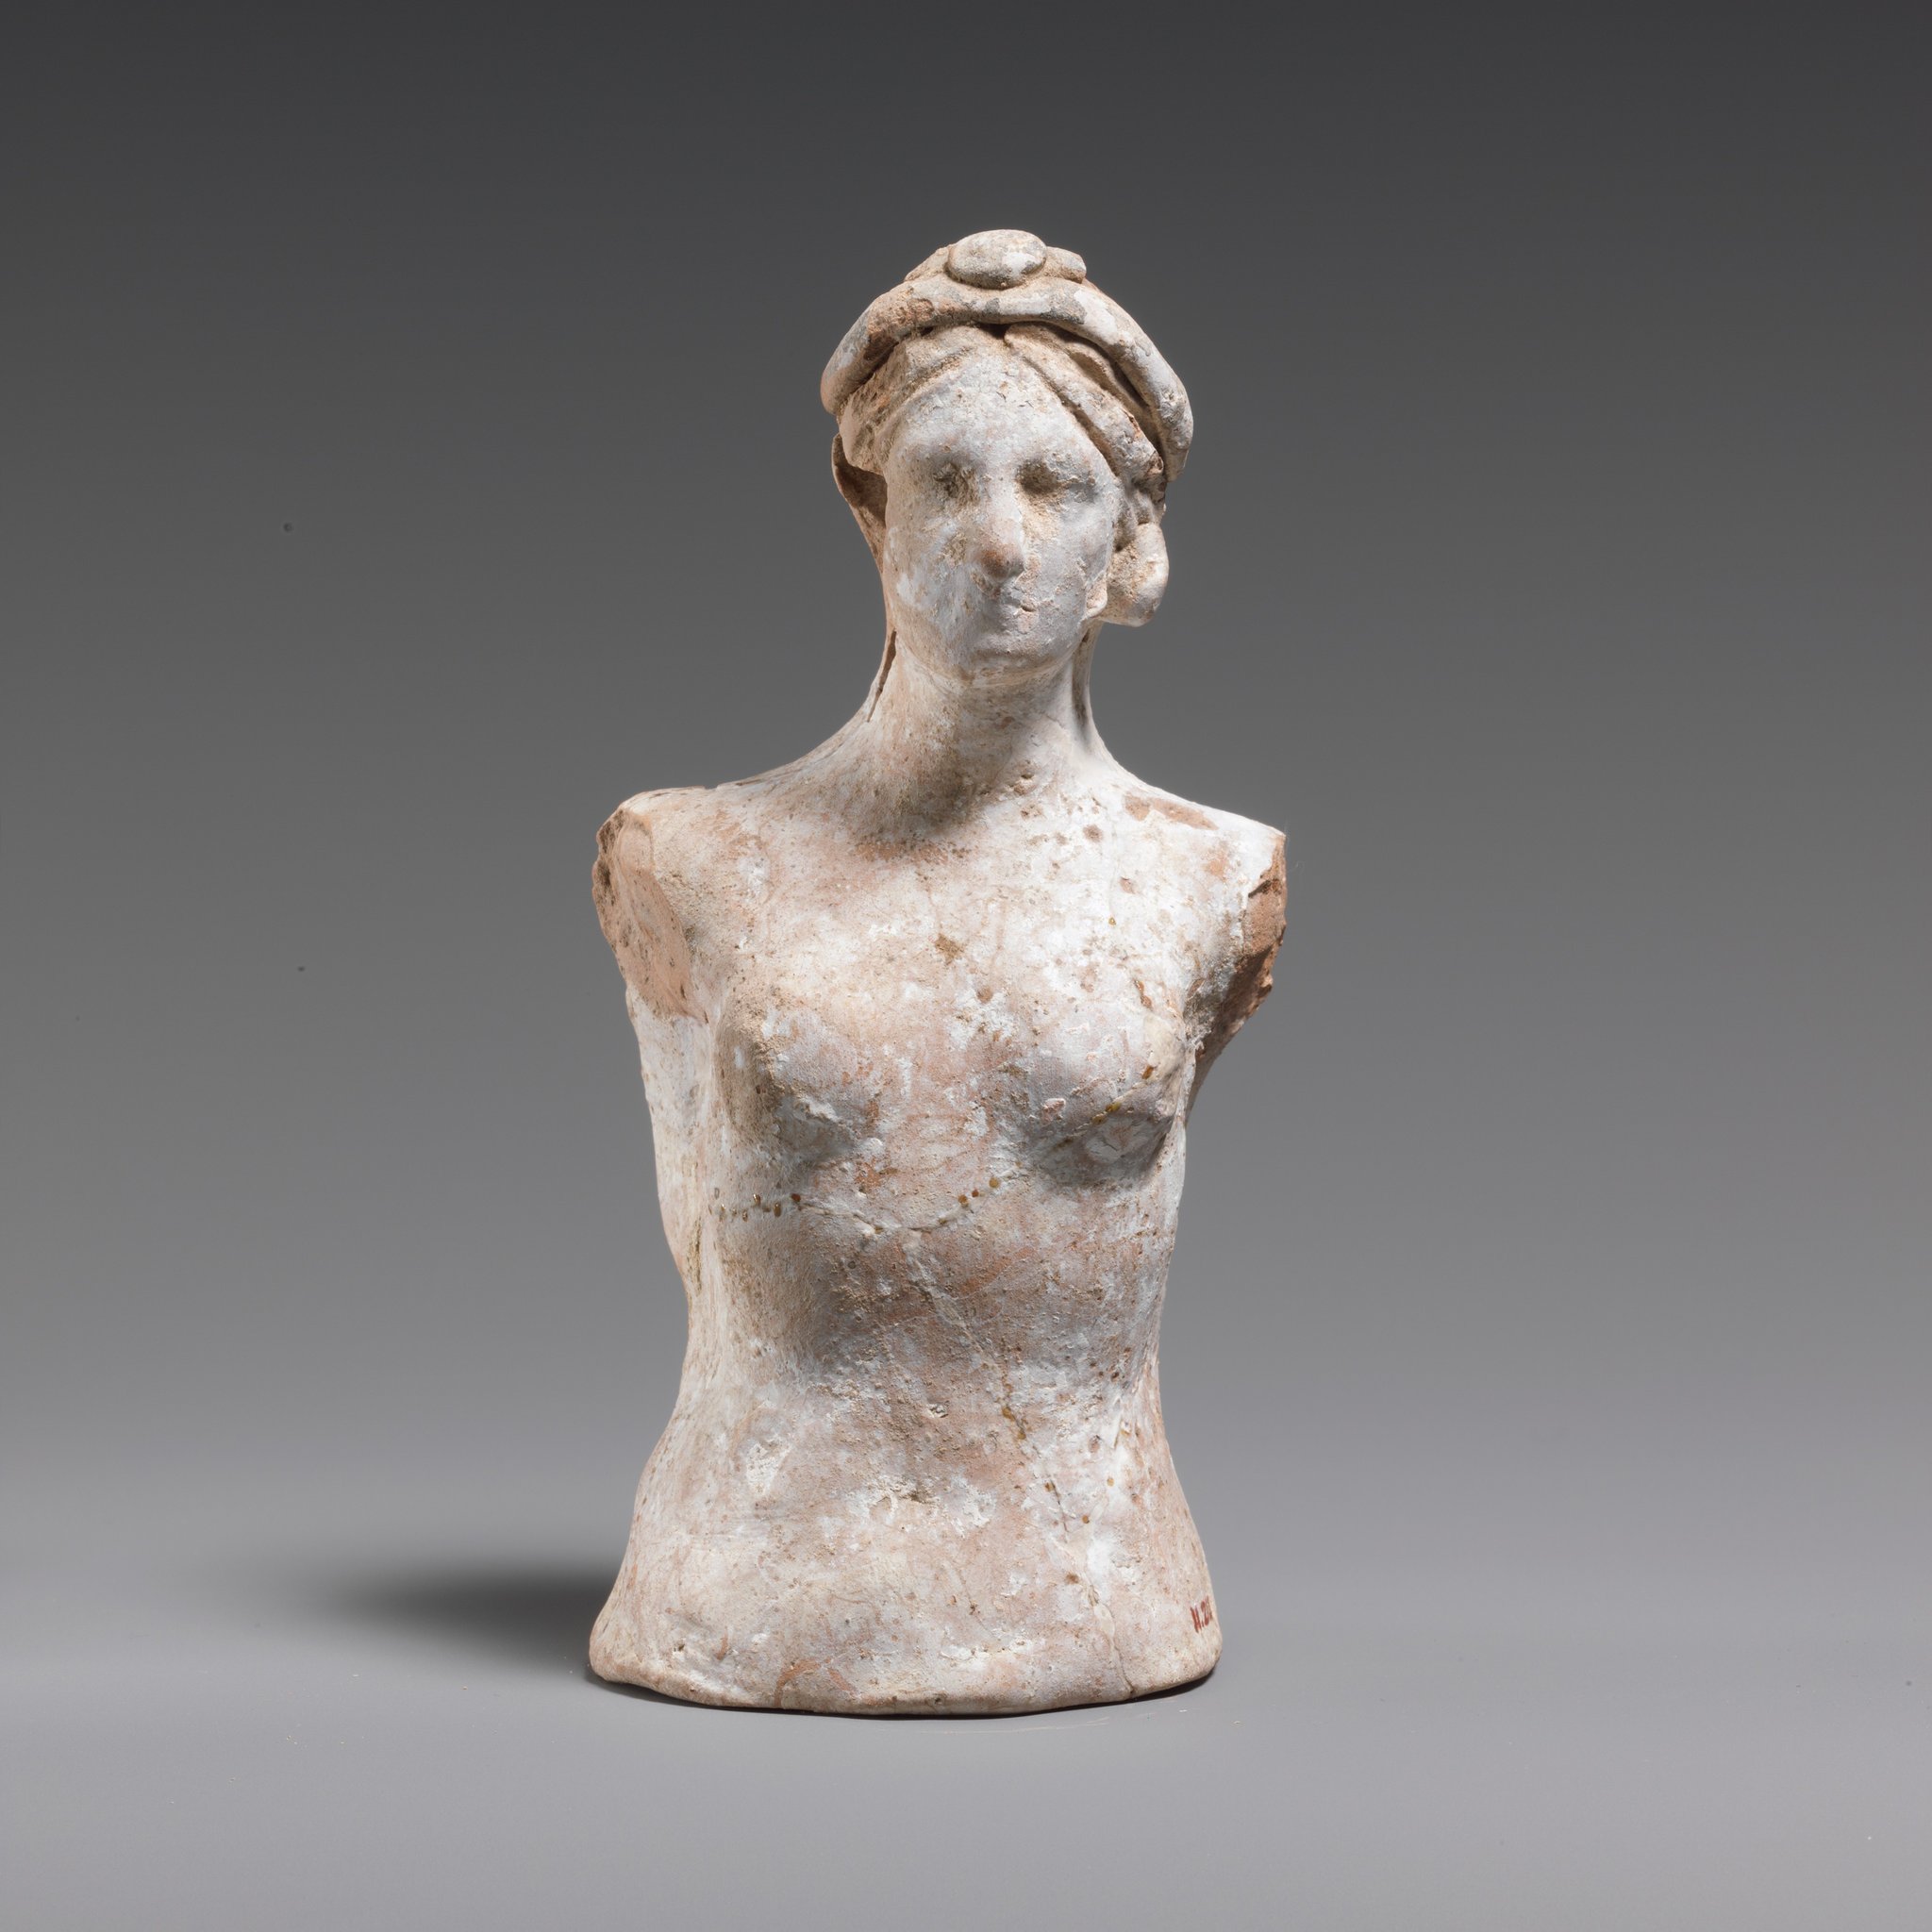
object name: bust of a woman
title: Terracotta bust of a woman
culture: greek, south italian, tarentine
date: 300-101 BCE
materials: terracotta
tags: women